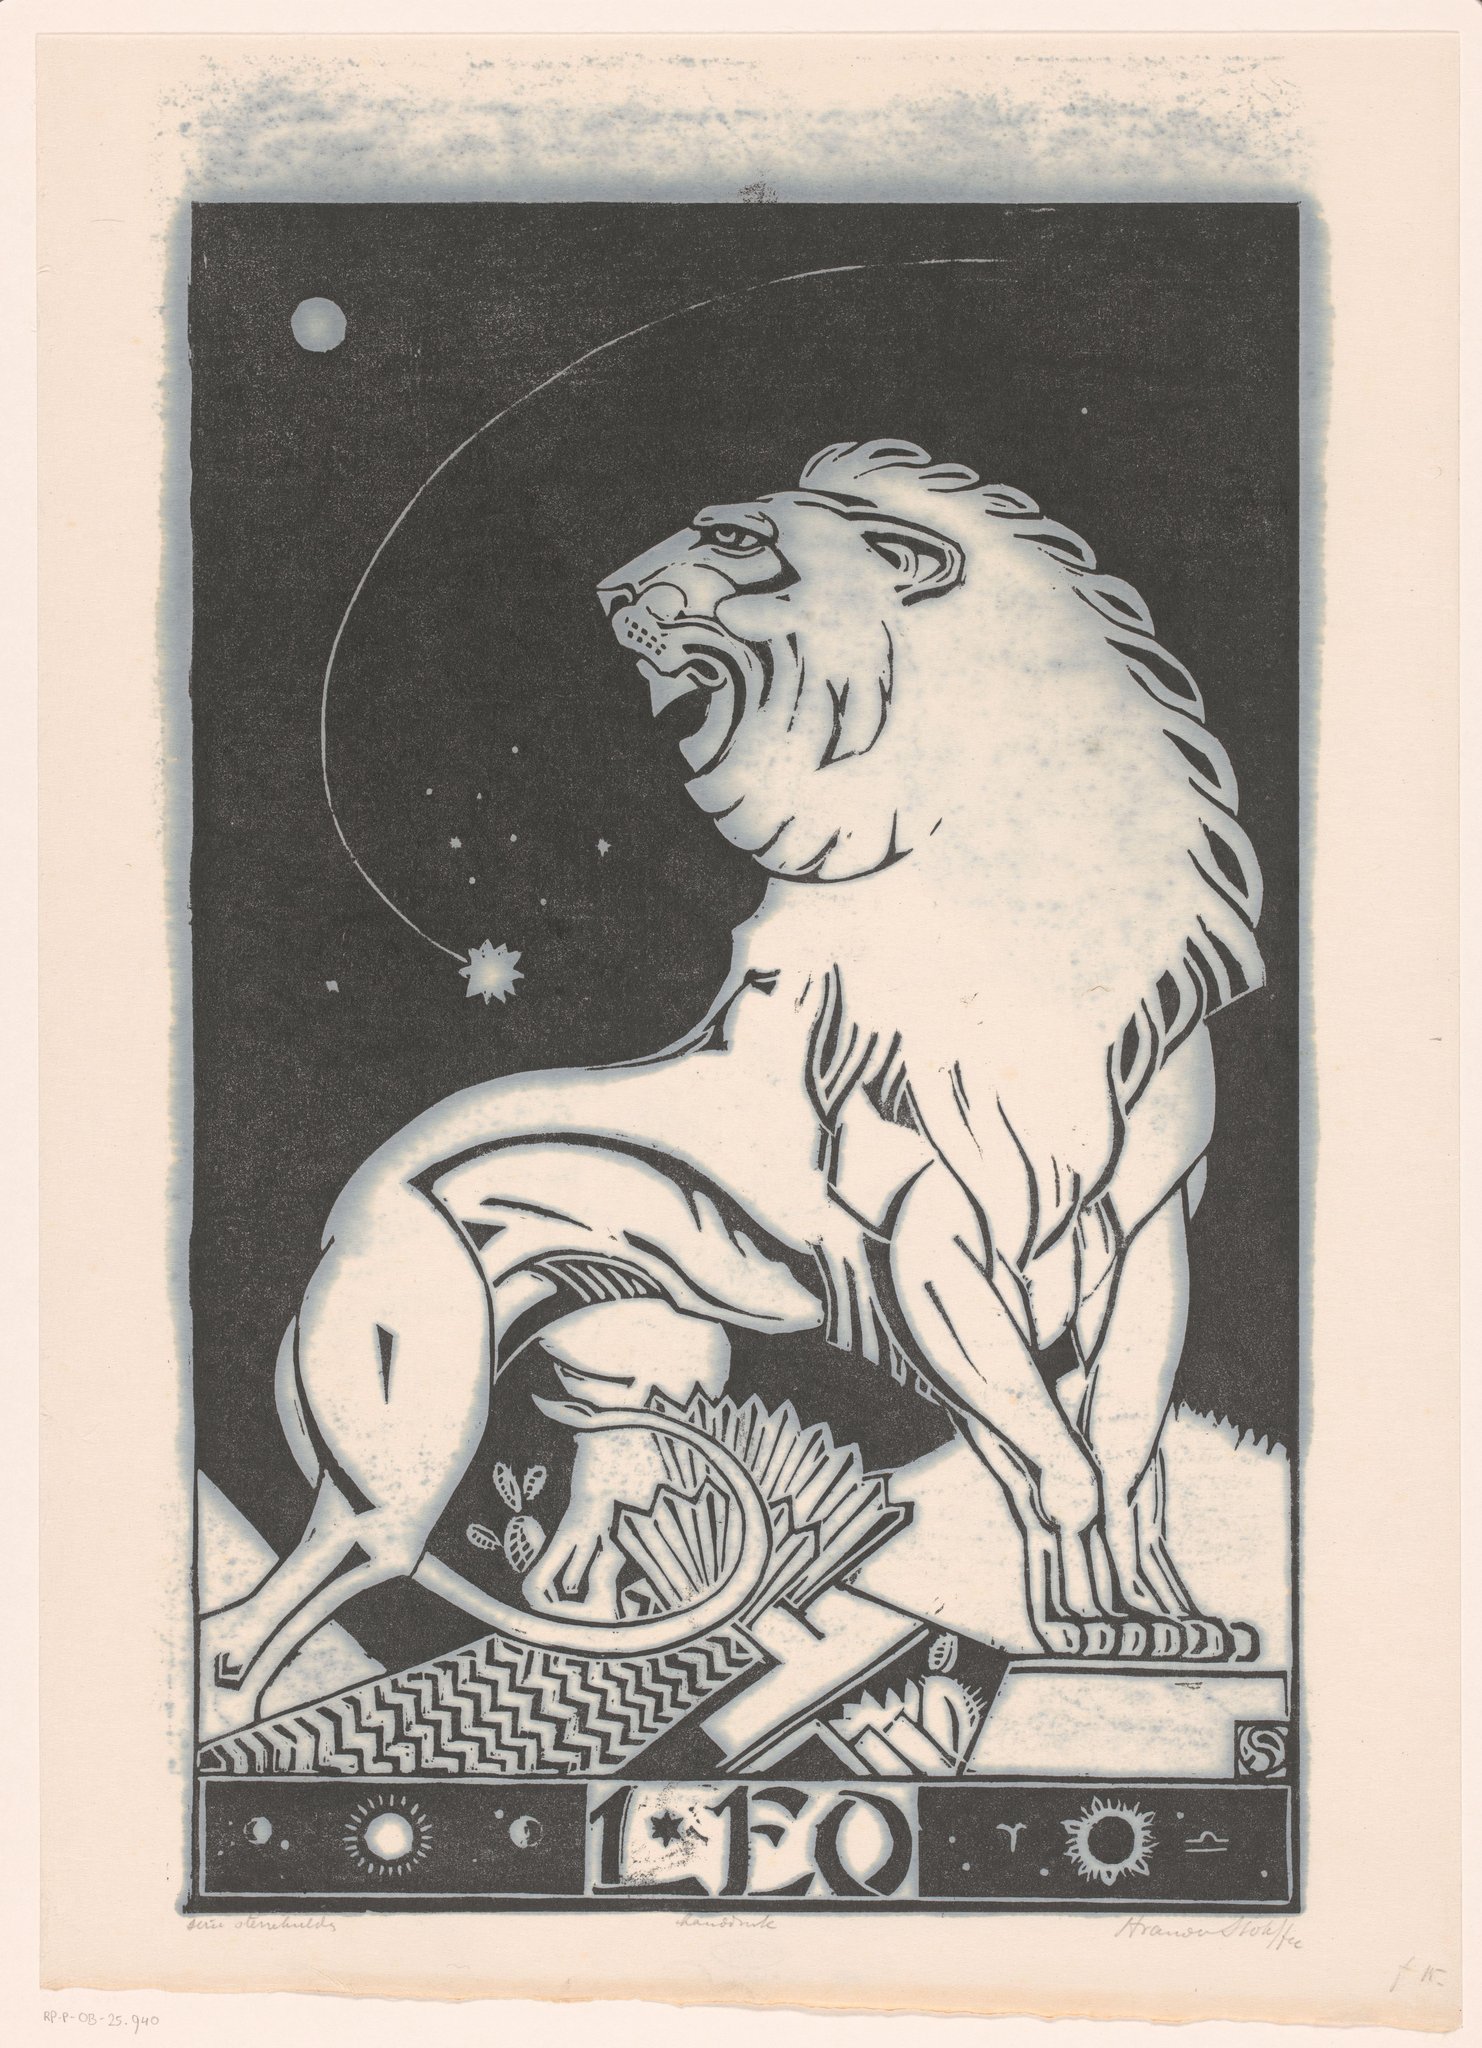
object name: print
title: Leo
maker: henri van der stok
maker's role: print maker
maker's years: 1870-1946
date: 1880-1946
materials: paper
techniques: woodcut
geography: netherlands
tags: leo (zodiacal sign of july)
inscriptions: collector's mark: Lugt 2228, inscription: ‘serie sterrebeelden’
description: Een opkijkende leeuw voor de sterrenhemel.